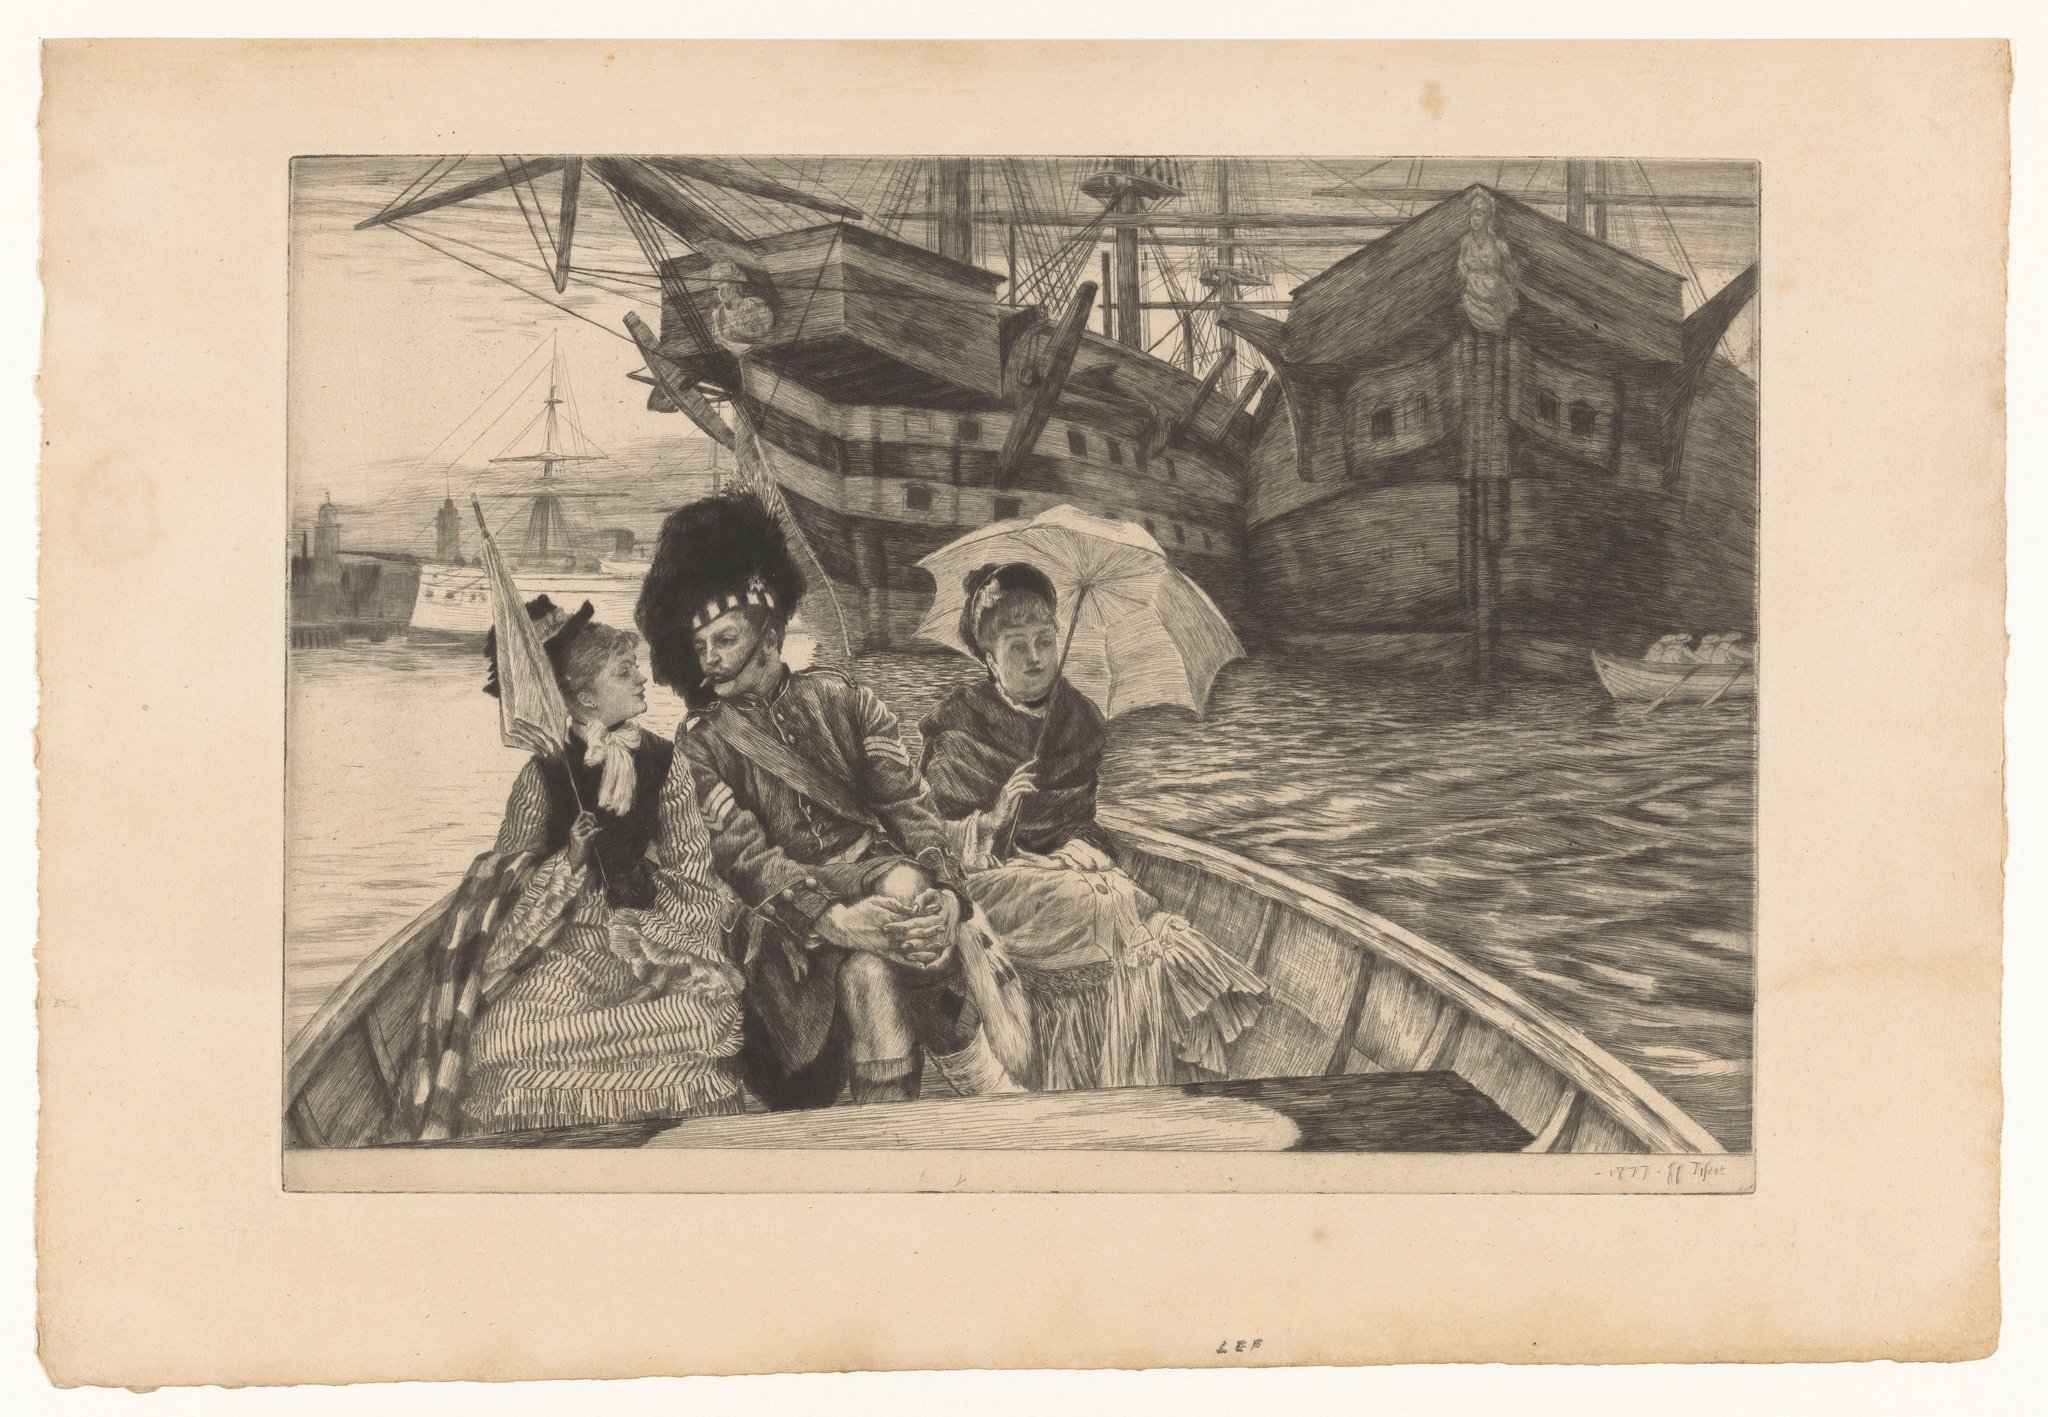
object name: print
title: Soldaat zittend tussen twee vrouwen in een boot met op de achtergrond twee schepen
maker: james tissot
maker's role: draughtsman, print maker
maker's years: 1836-1902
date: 1877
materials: paper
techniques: drypoint, etching, intaglio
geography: london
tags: private soldier, courting, parasol, sunshade, boat propelled by man or animal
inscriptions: inscription: ‘LEF’, collector's mark: Lugt 2760, collector's mark: Lugt 2228